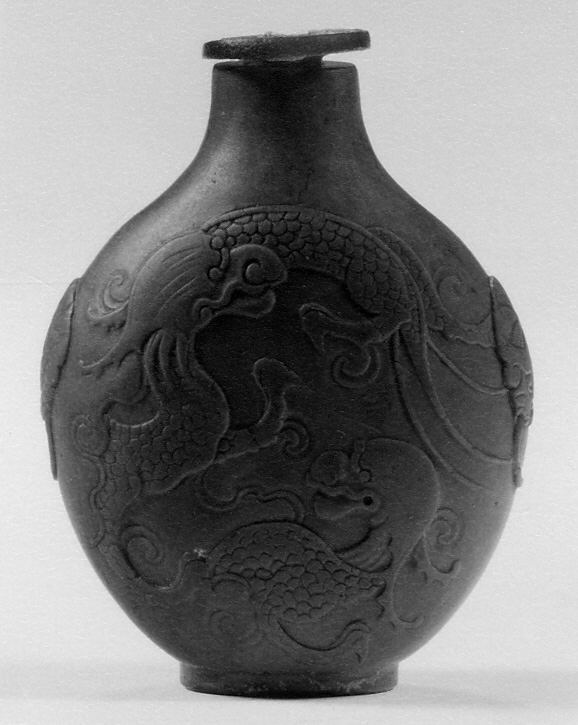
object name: snuff bottle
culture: chinese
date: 1801-1900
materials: clay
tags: dragons